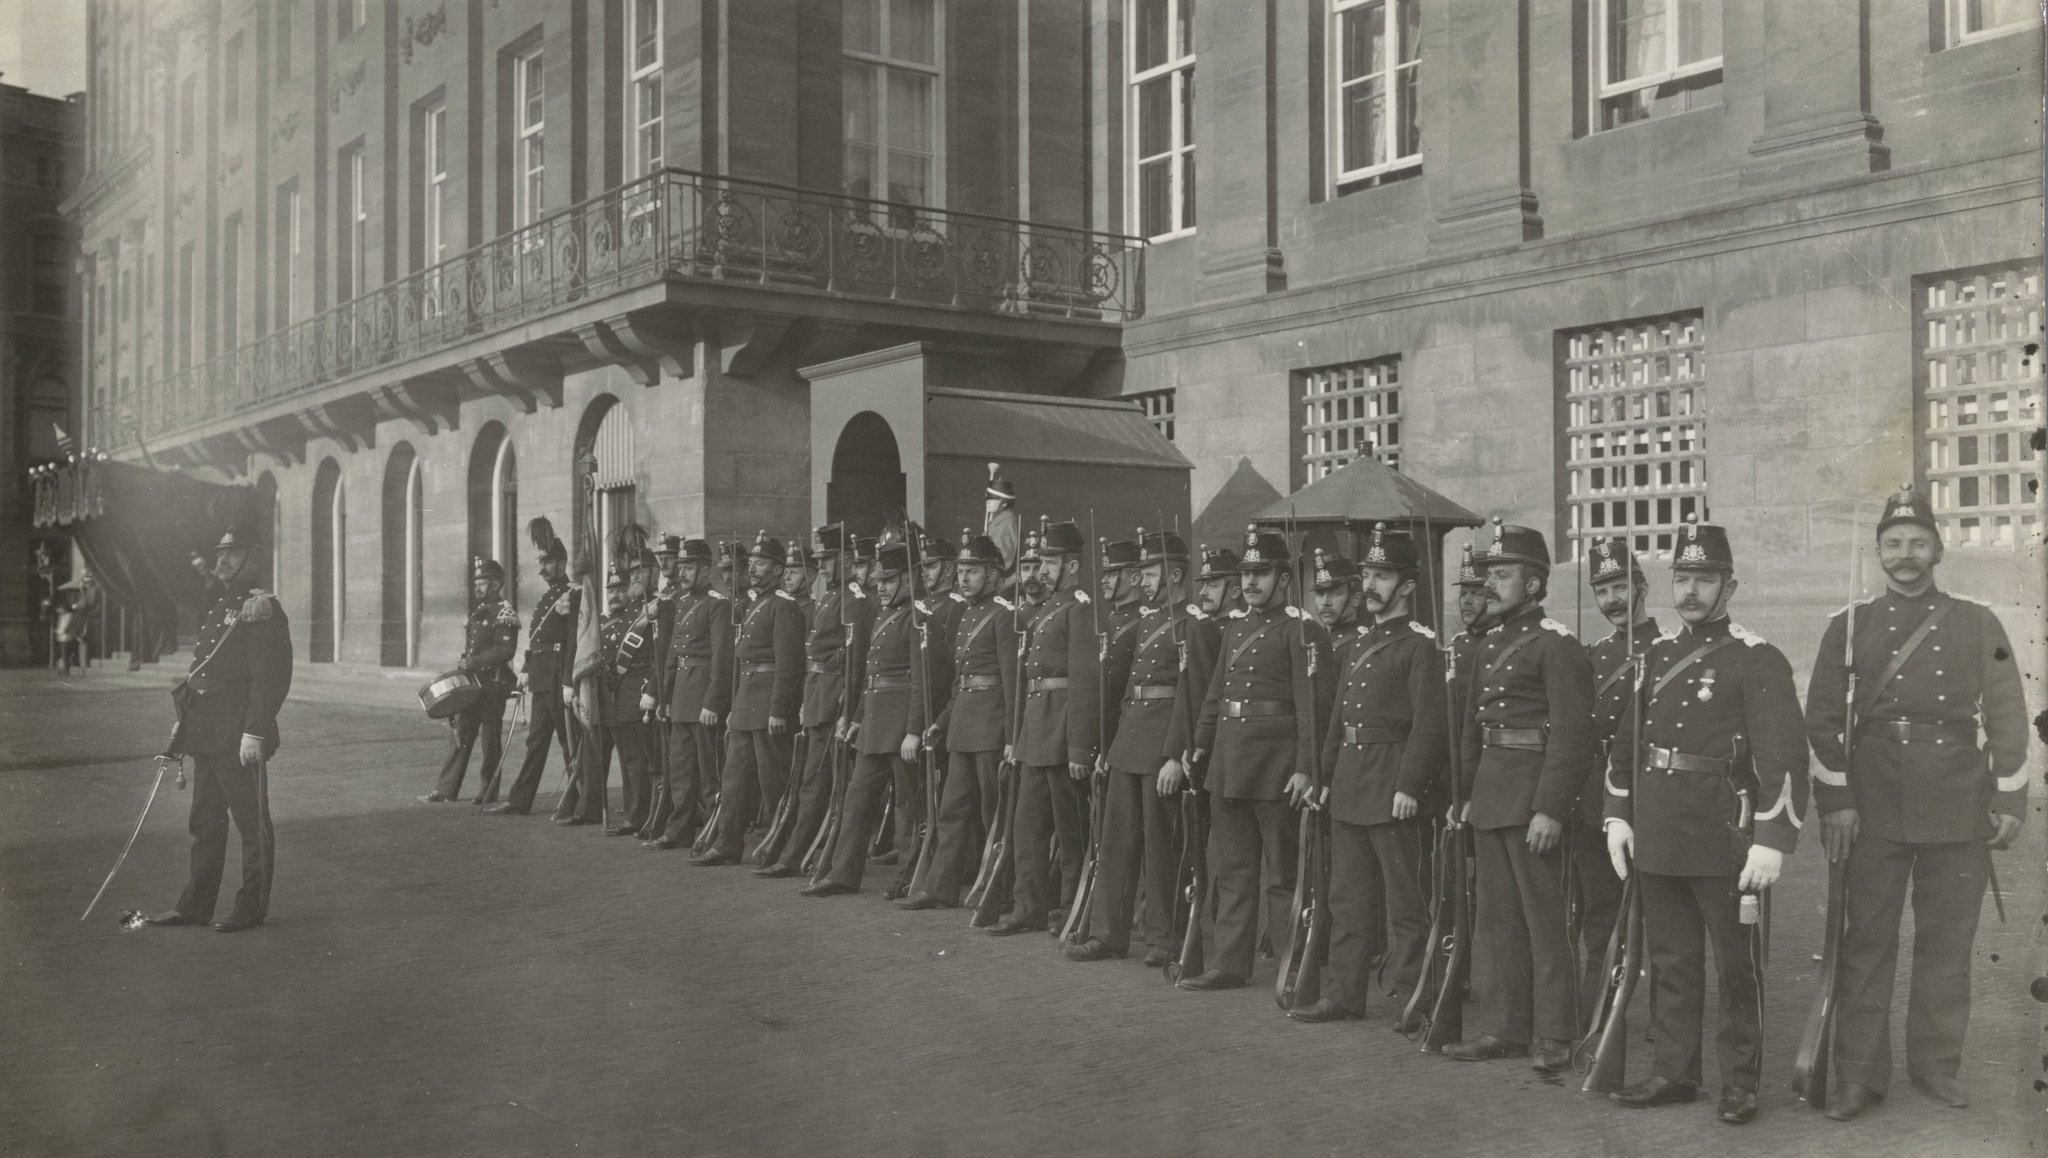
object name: photograph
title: Groepsportret van de schutterij voor het koninklijk paleis op de Dam in Amsterdam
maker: Anonymous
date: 1910-1940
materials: photographic support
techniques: gelatin silver print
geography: amsterdam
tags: dam